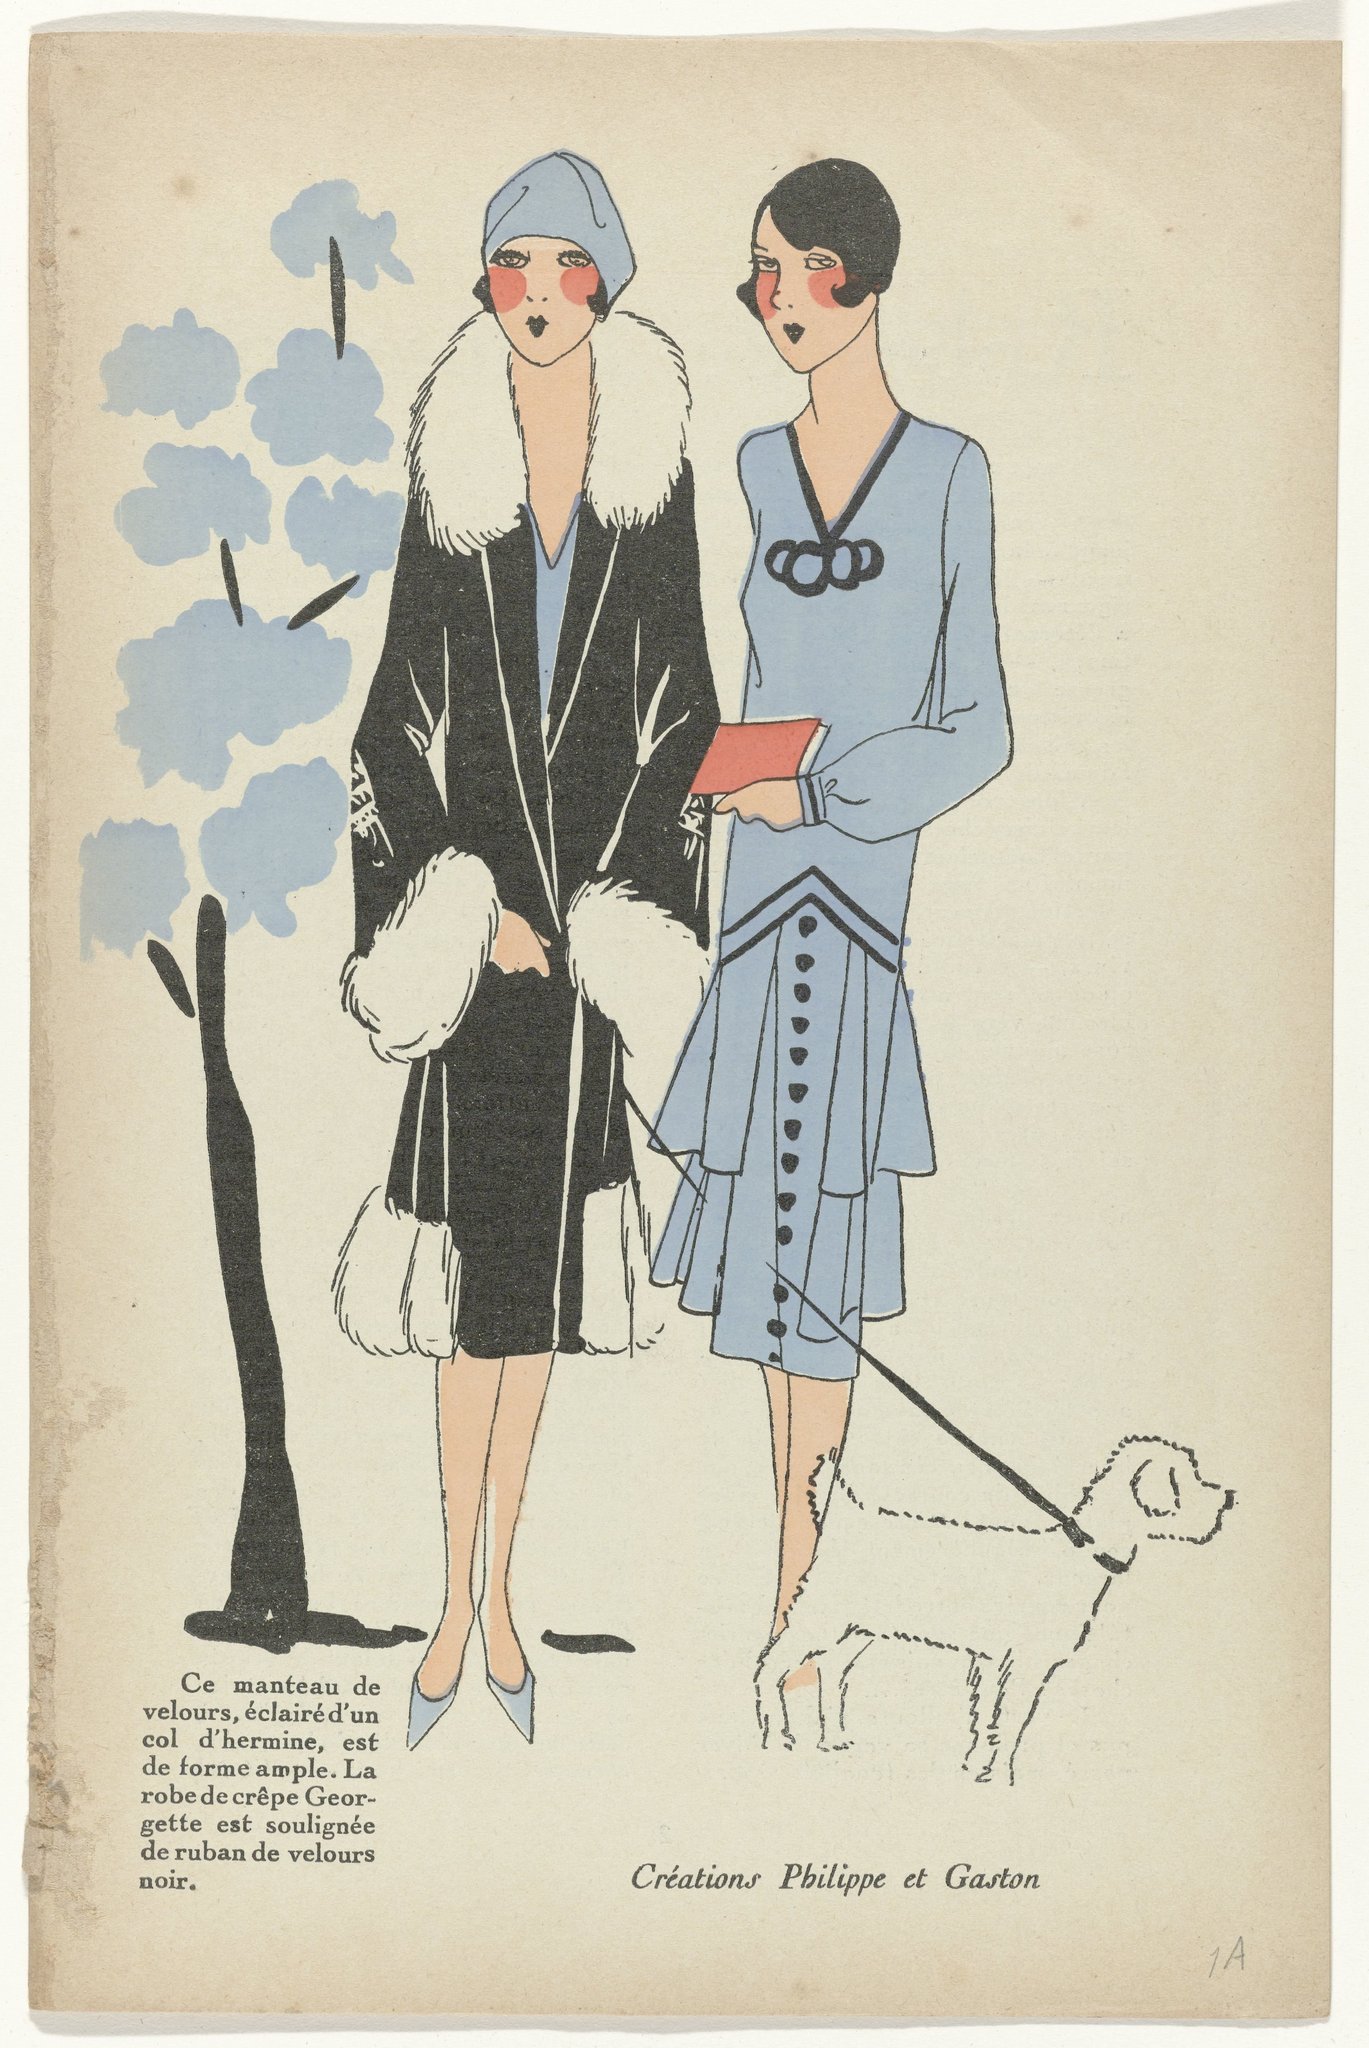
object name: fashion print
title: Très Parisien, 1926, No. 1, pag. 1: Créations Philippe et Gaston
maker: g-p. joumard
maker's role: publisher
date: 1926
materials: paper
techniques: hand coloring, letterpress printing, lithography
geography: paris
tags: dress, gown: day dress (+ women's clothes), coat (+ women's clothes), fashion plates, walking the dog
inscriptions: date: ‘Créations Philippe et Gaston. Ce manteau de velours, éclairé d'un col d'hermine, est de forme ample. La robe de crêpe Georgette est soulignée de rubans de velours noir.’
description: Creaties van het modehuis Philippe et Gaston. Mantel van fluweel met kraag van hermelijn. Japon van crêpe Georgette met banden van zwart fluweel. Pagina 1 uit Très Parisien, No. 1, 1926